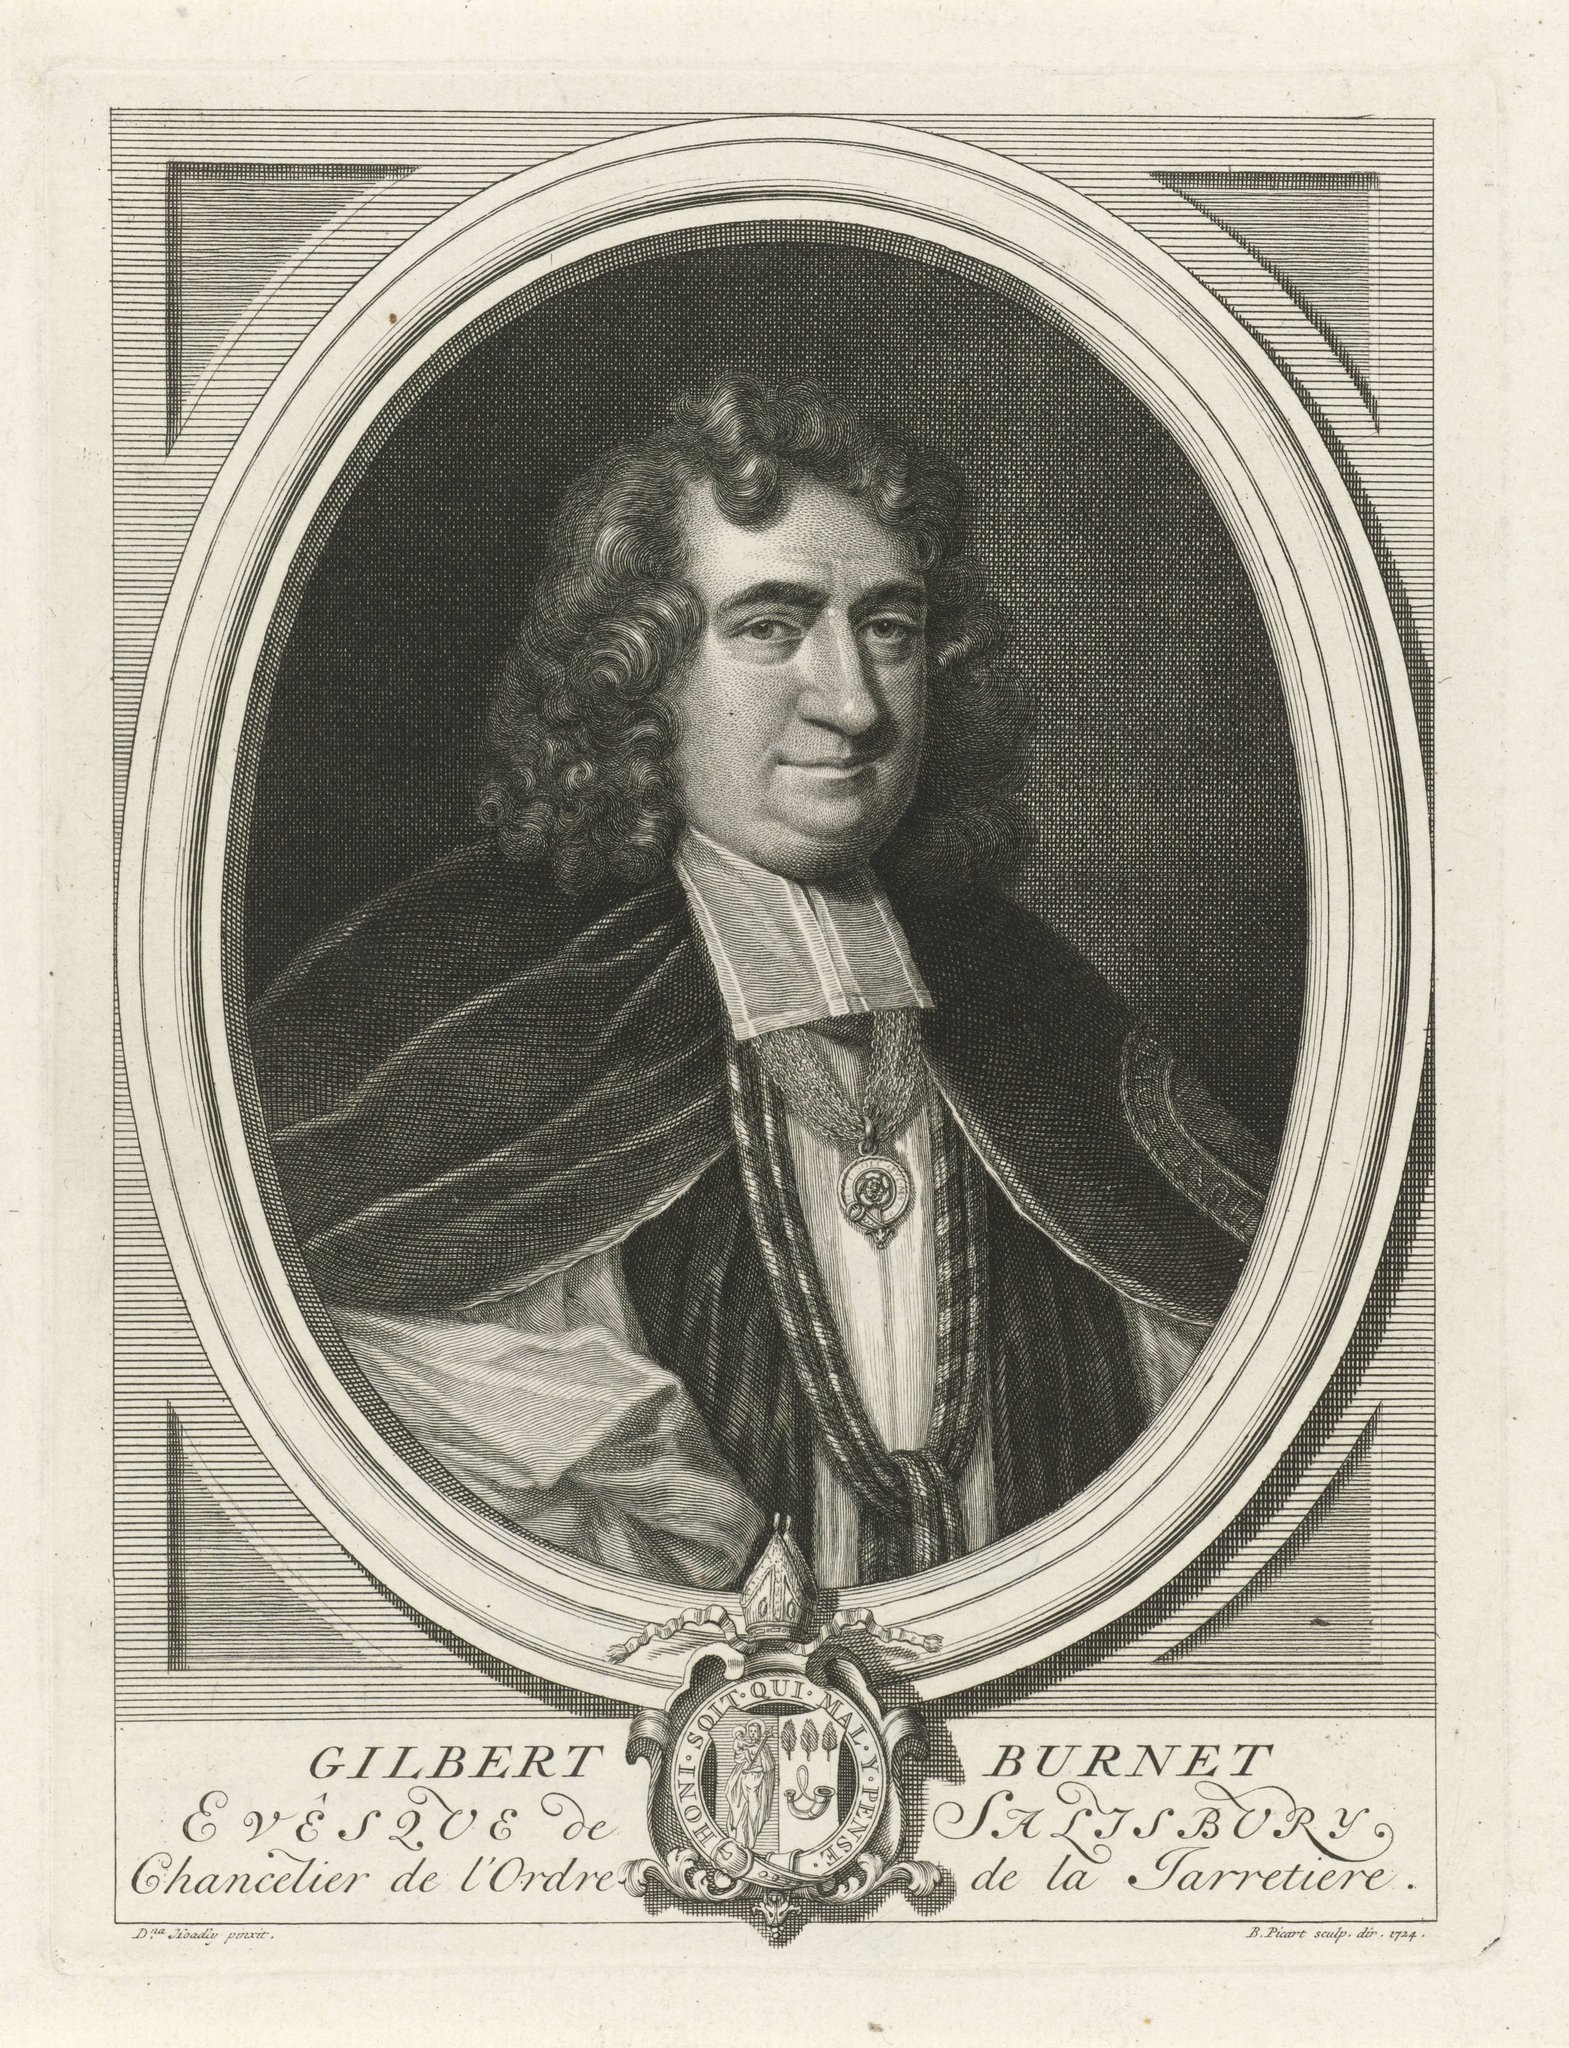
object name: print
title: Portret van Gilbert Burnet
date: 1724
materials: paper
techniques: engraving, etching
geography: amsterdam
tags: clergyman, archbishop, bishop, etc. (roman catholic), knighthood order (garter)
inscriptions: collector's mark: Lugt 2228, collector's mark: Lugt 2760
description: Portret van Gilbert Burnet, bisschop van Salisbury. Hij draagt een keten met de Orde van de Kousenband. In de marge zijn wapenschild.